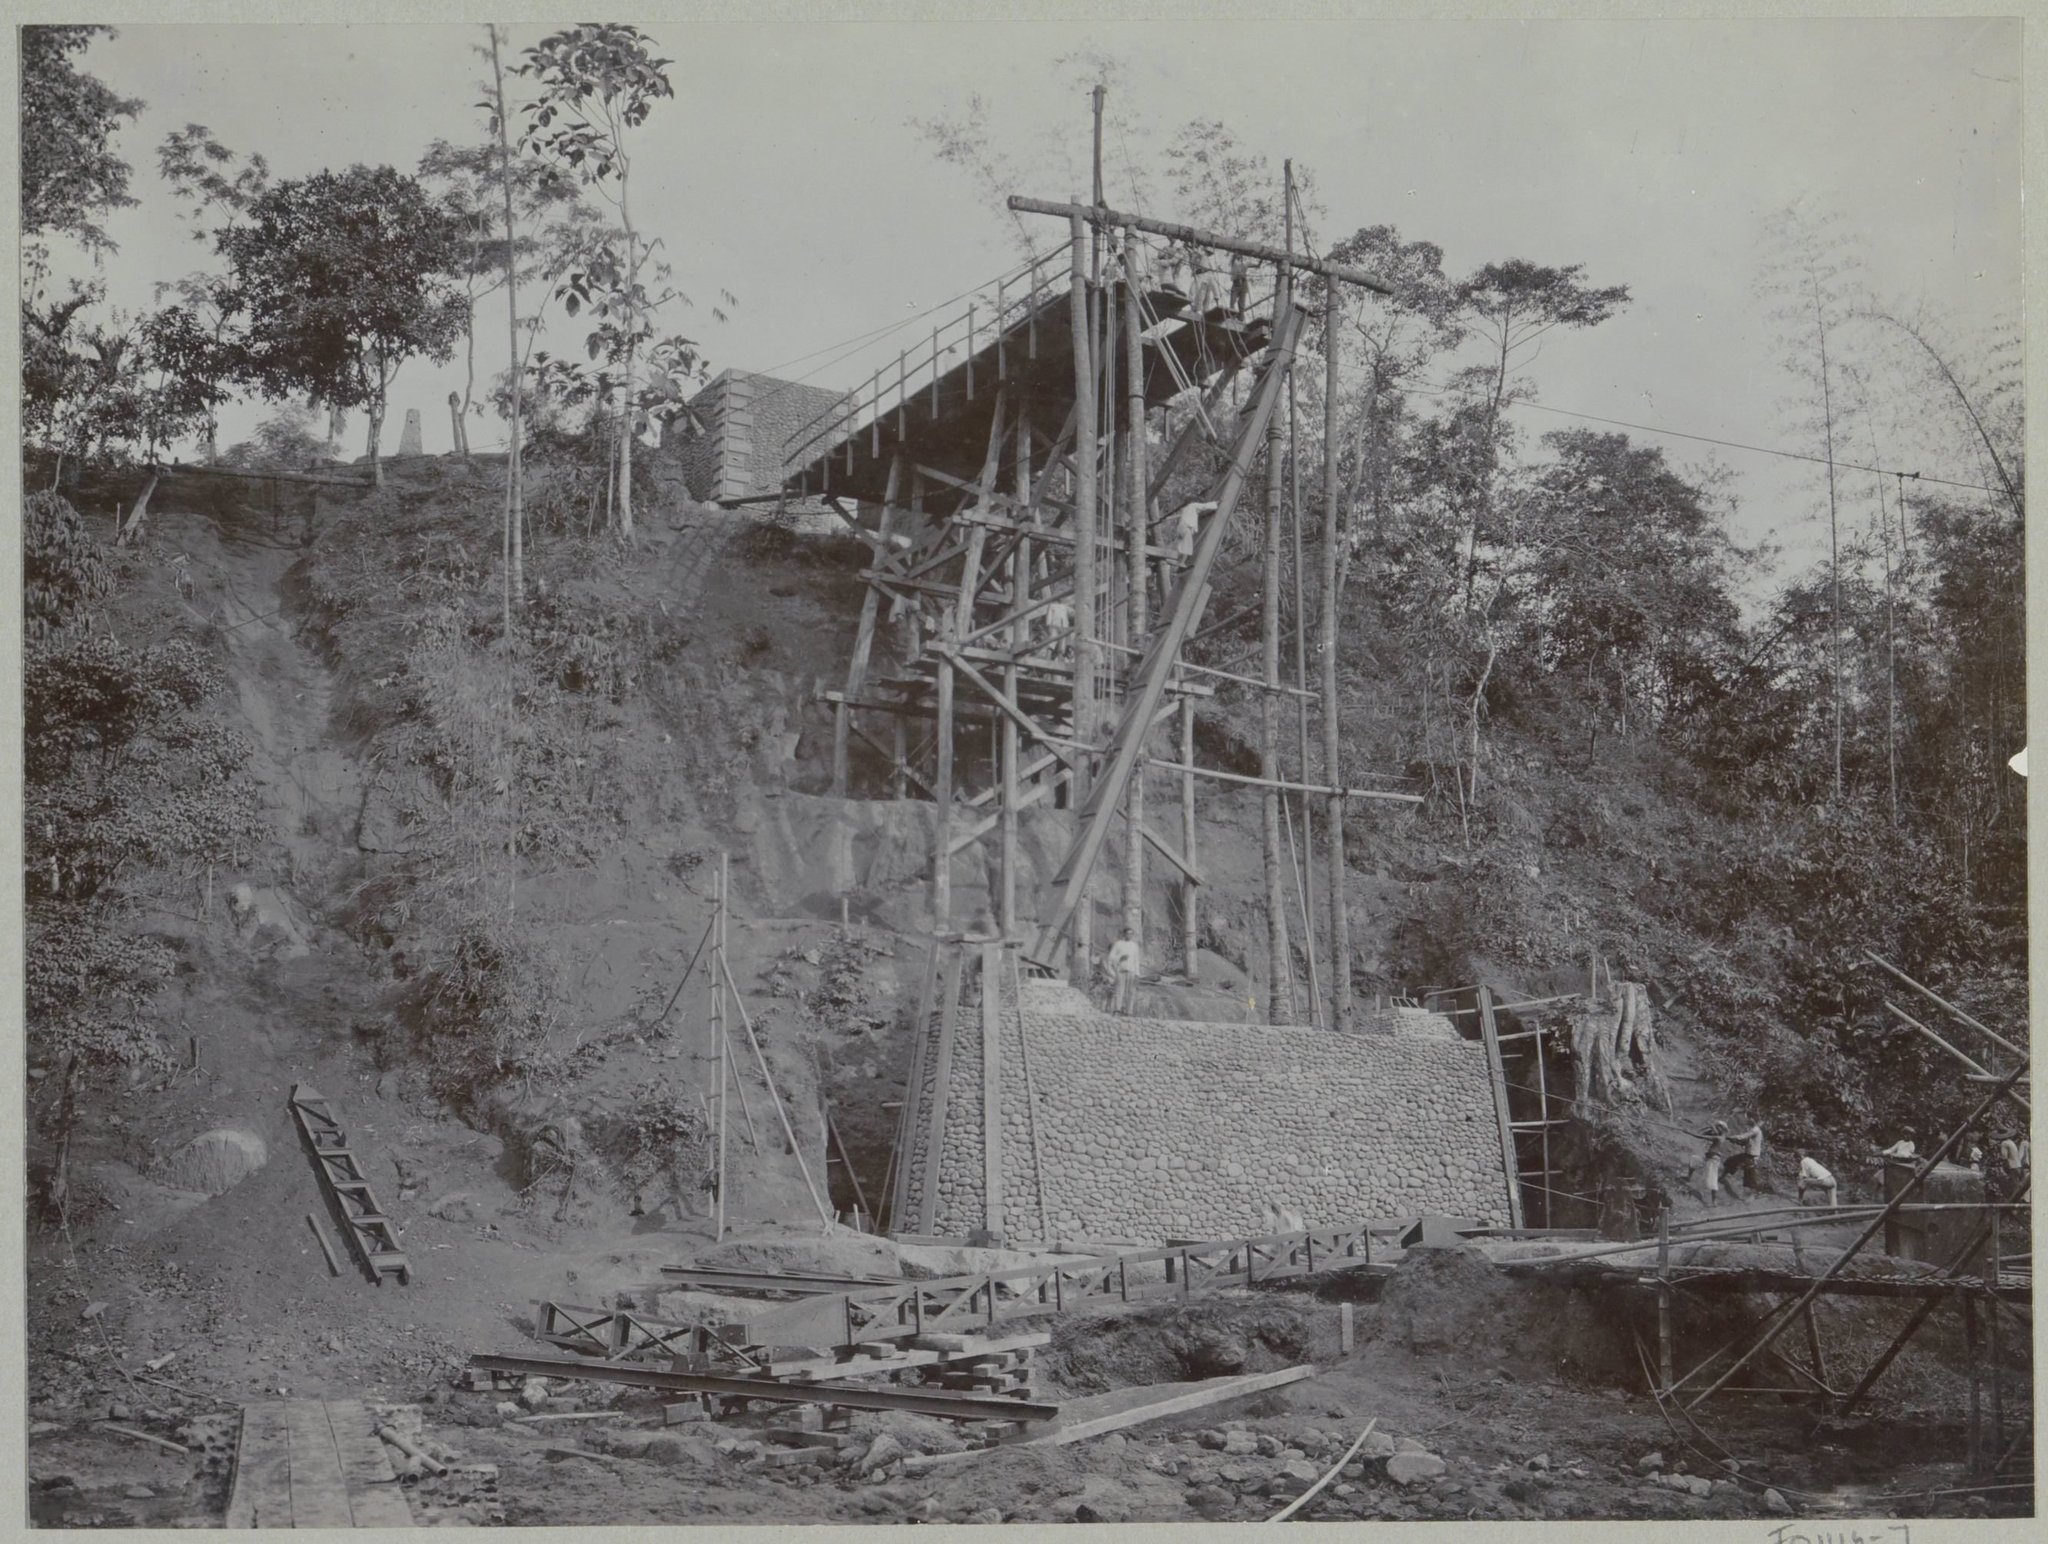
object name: photograph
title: Gereed landhoofd van brug met opgehesen brugpijler op de oostelijke oever van de Kali Brantas ten zuiden van Malang (Photo X)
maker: Anonymous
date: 1890-1920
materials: cardboard, paper, photographic support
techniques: gelatin silver print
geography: java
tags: engineering, landscape with bridge, viaduct or aqueduct, bridge, building-site, java, dutch east indies, the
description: Foto met op de linkerpagina het bijbehorende bijschrift. Onderdeel van Fotoalbum met opnames van de bouw van een brug over de Kali Brantas ten zuiden van Malang op Java.